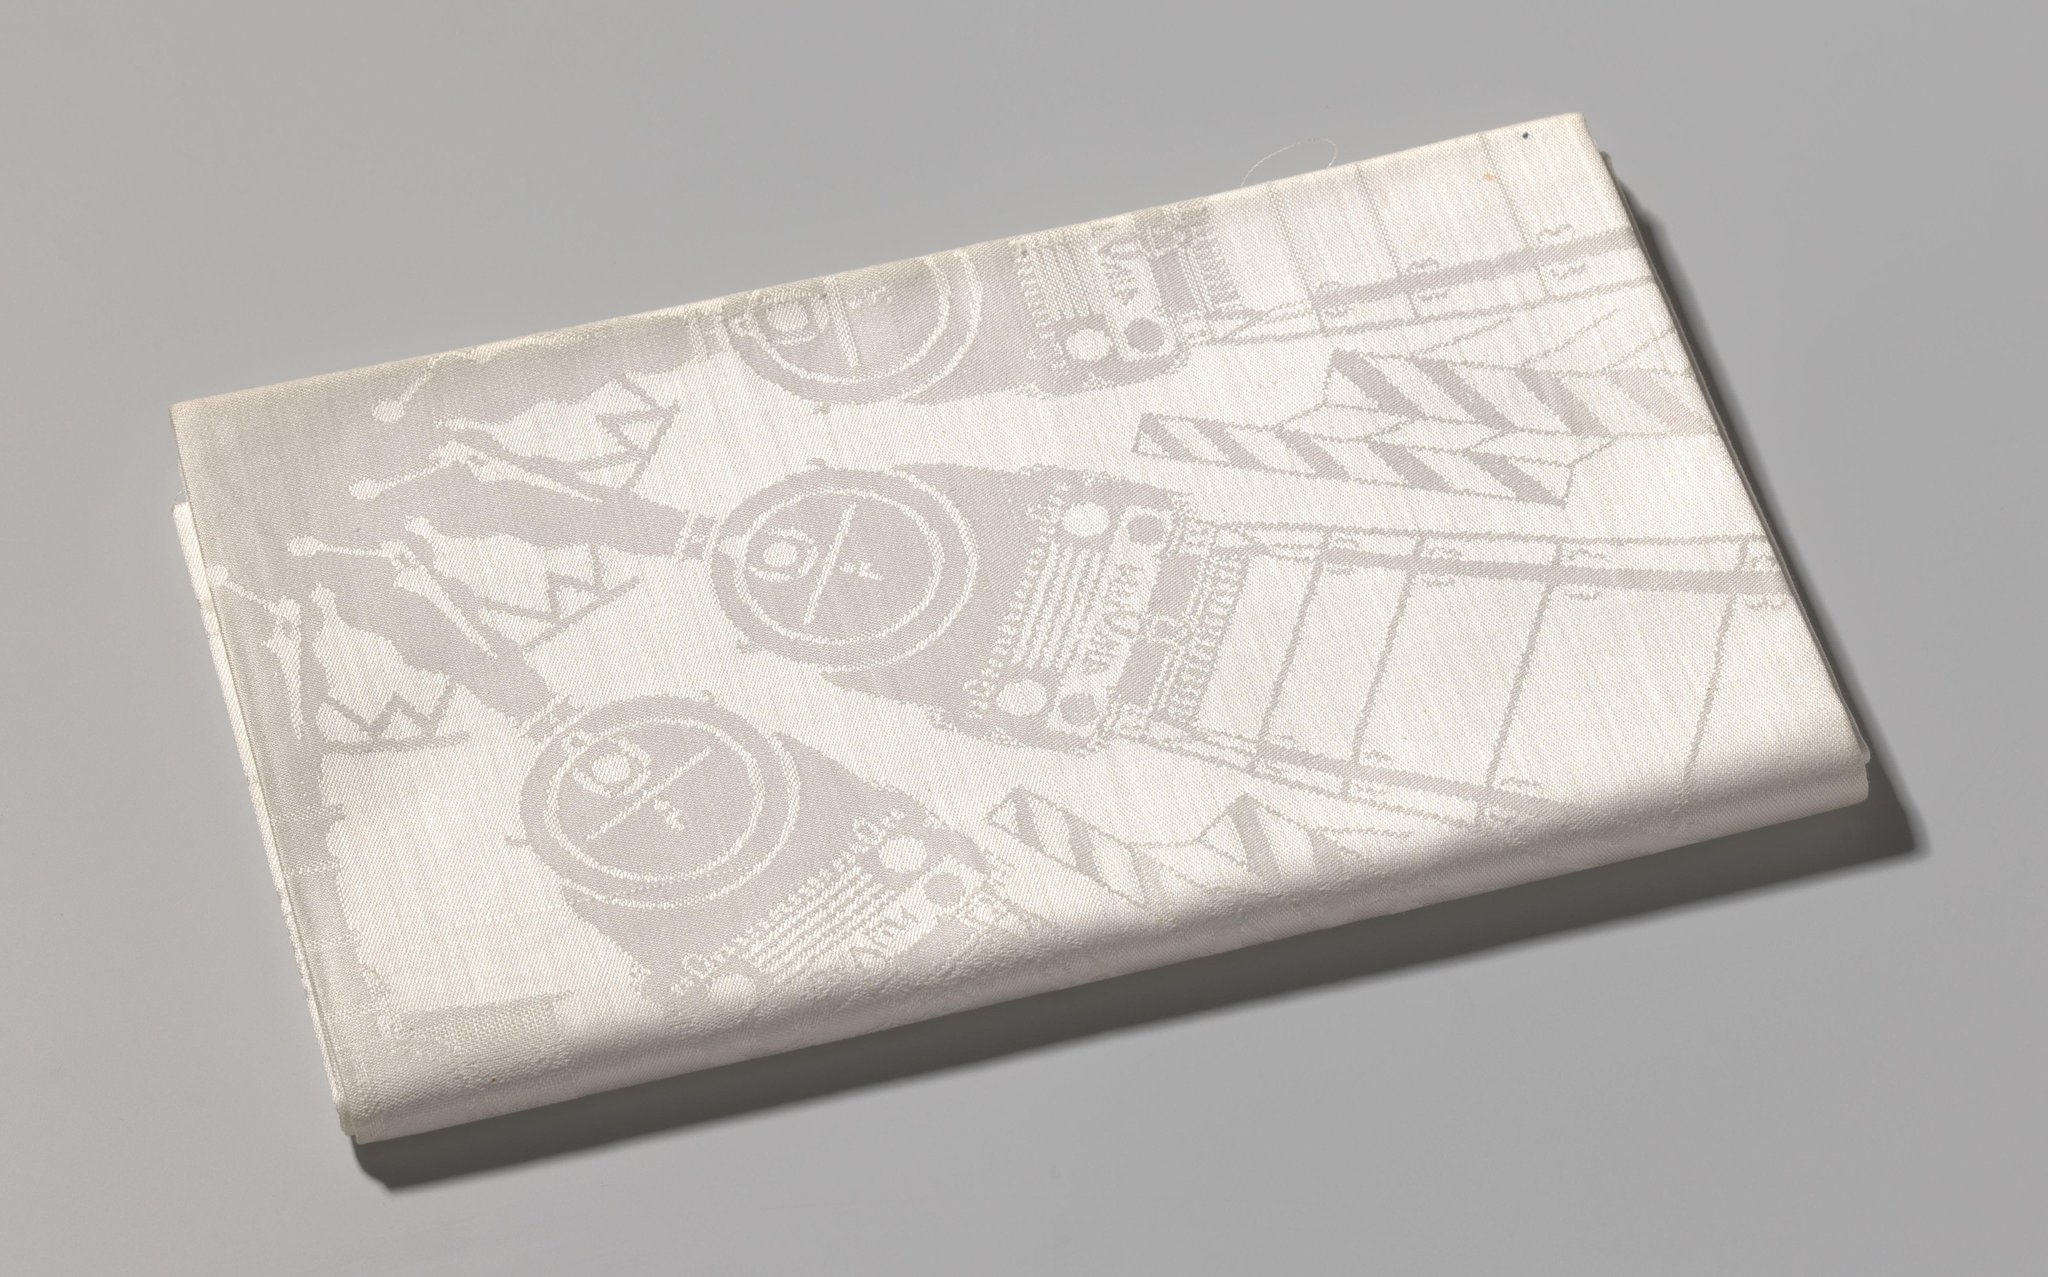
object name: tablecloth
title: Tafellaken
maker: Anonymous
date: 1939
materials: linen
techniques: damask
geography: eindhoven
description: Linnen damasten tafellaken ter herdenking van "Een eeuw Spoor", "1838-1939" (ingeweven).